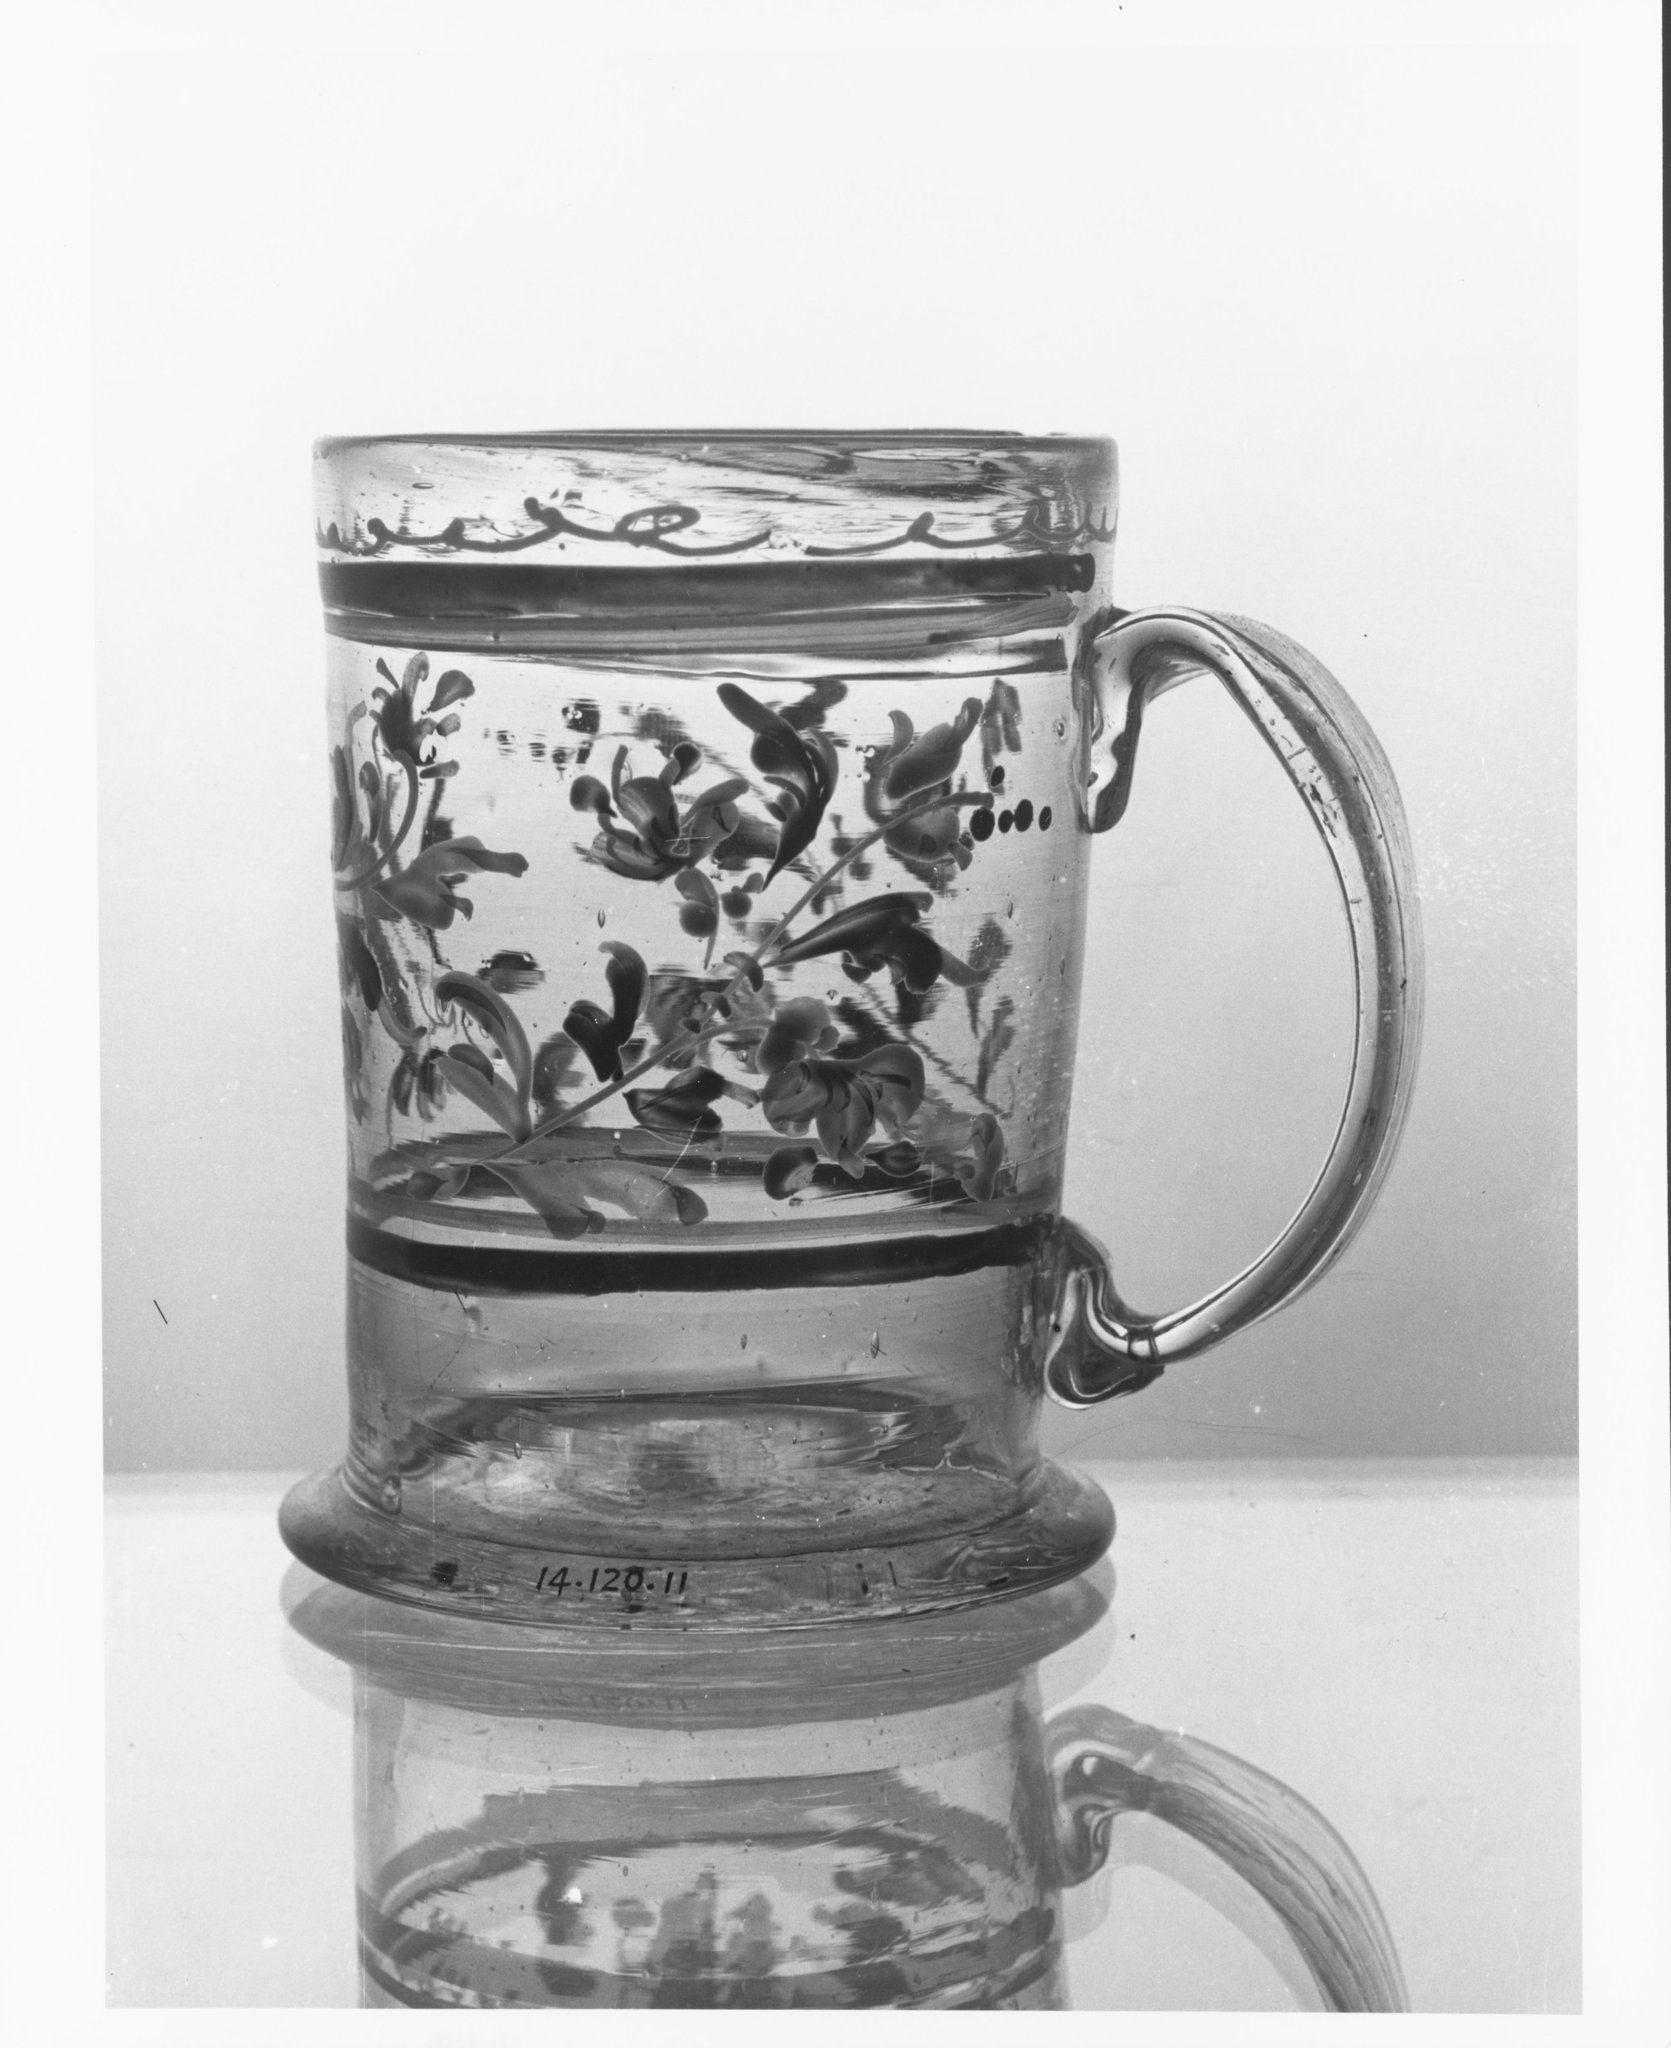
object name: mug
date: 1701-1800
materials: enamel, glass, lead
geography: czech republic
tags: flowers